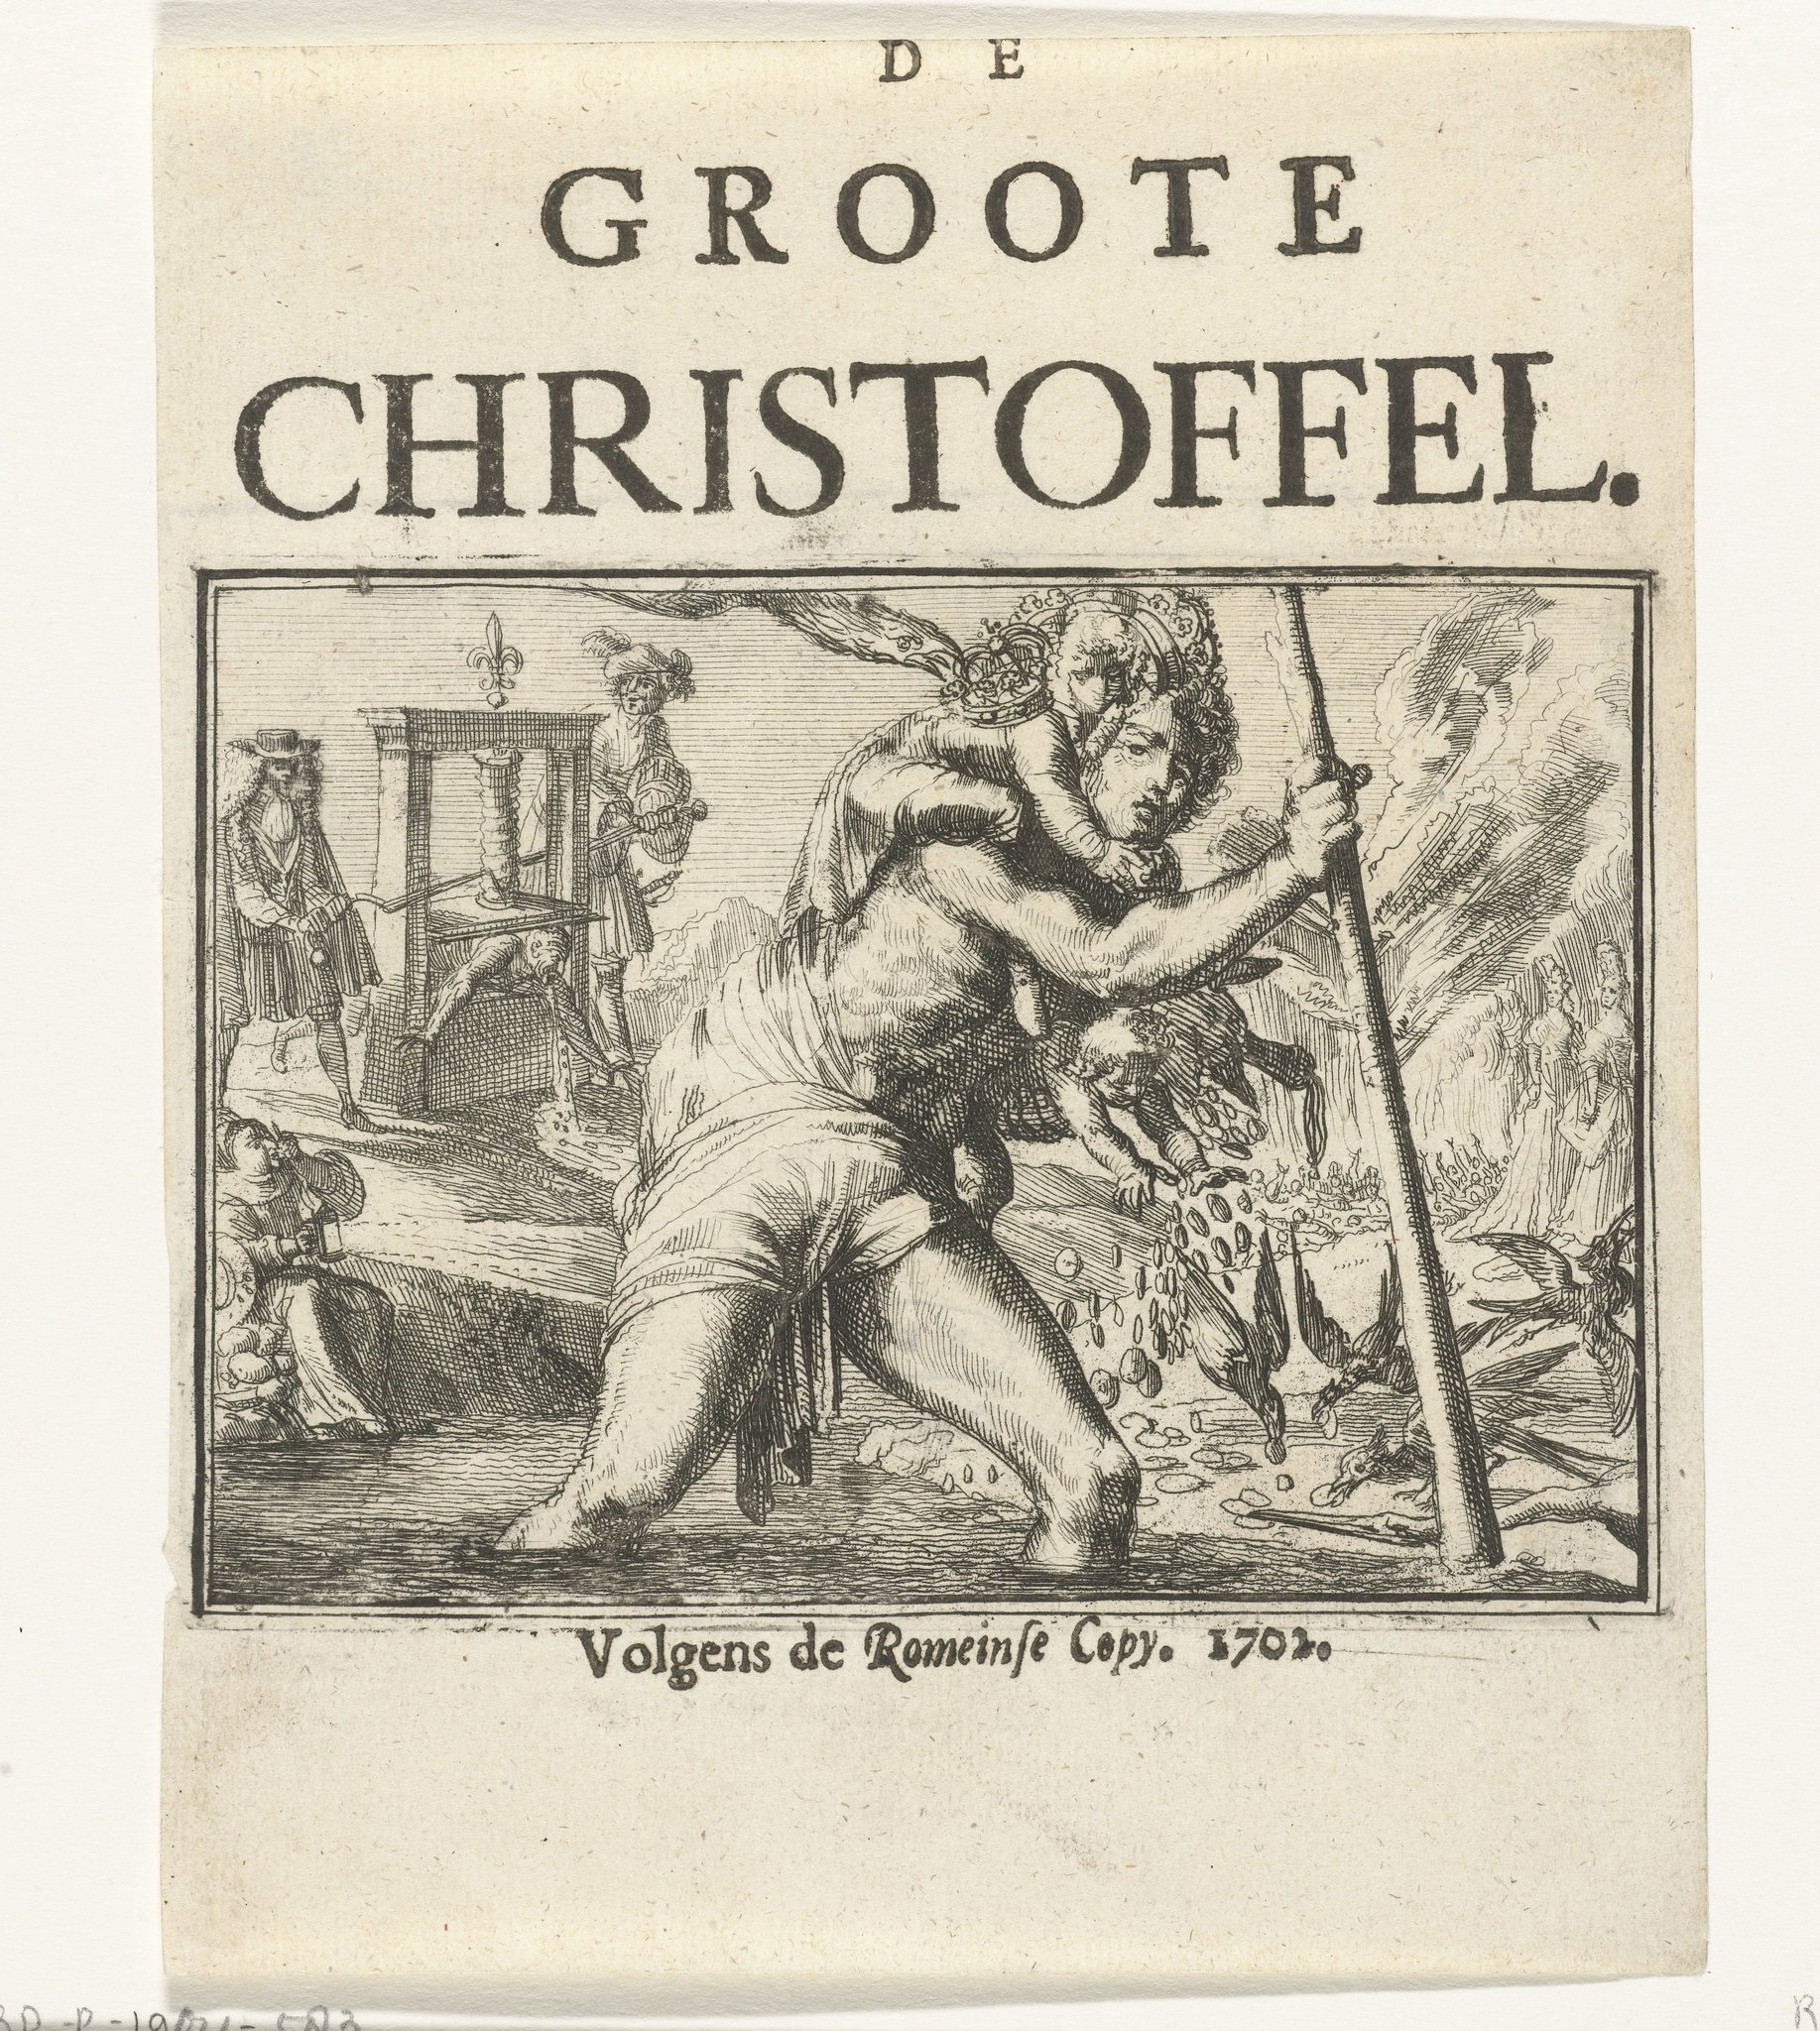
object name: print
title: De Groote Christoffel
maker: romeyn de hooghe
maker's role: draughtsman, goldsmith, painter, print maker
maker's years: 1645-1708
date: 1702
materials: paper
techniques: etching, letterpress printing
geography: northern netherlands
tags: lodewijk xiv (koning van frankrijk), rome, filips v (koning van spanje), printing press, the giant and martyr christophorus; possible attributes: palm-tree (with bunches of dates, or withered), infant christ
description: Titelblad voor het pamflet: De Groote Christoffel, 1702. Droom van Lodewijk XIV als de heilige Christoffel met op zijn schouders en onder de arm de pretendent en zijn kleinzoon Filips van Anjou. Op de achtergrond wordt een persoon (het Franse volk) uitgeperst in een Franse drukpers aangedraaid door een Franse minister en soldaat.